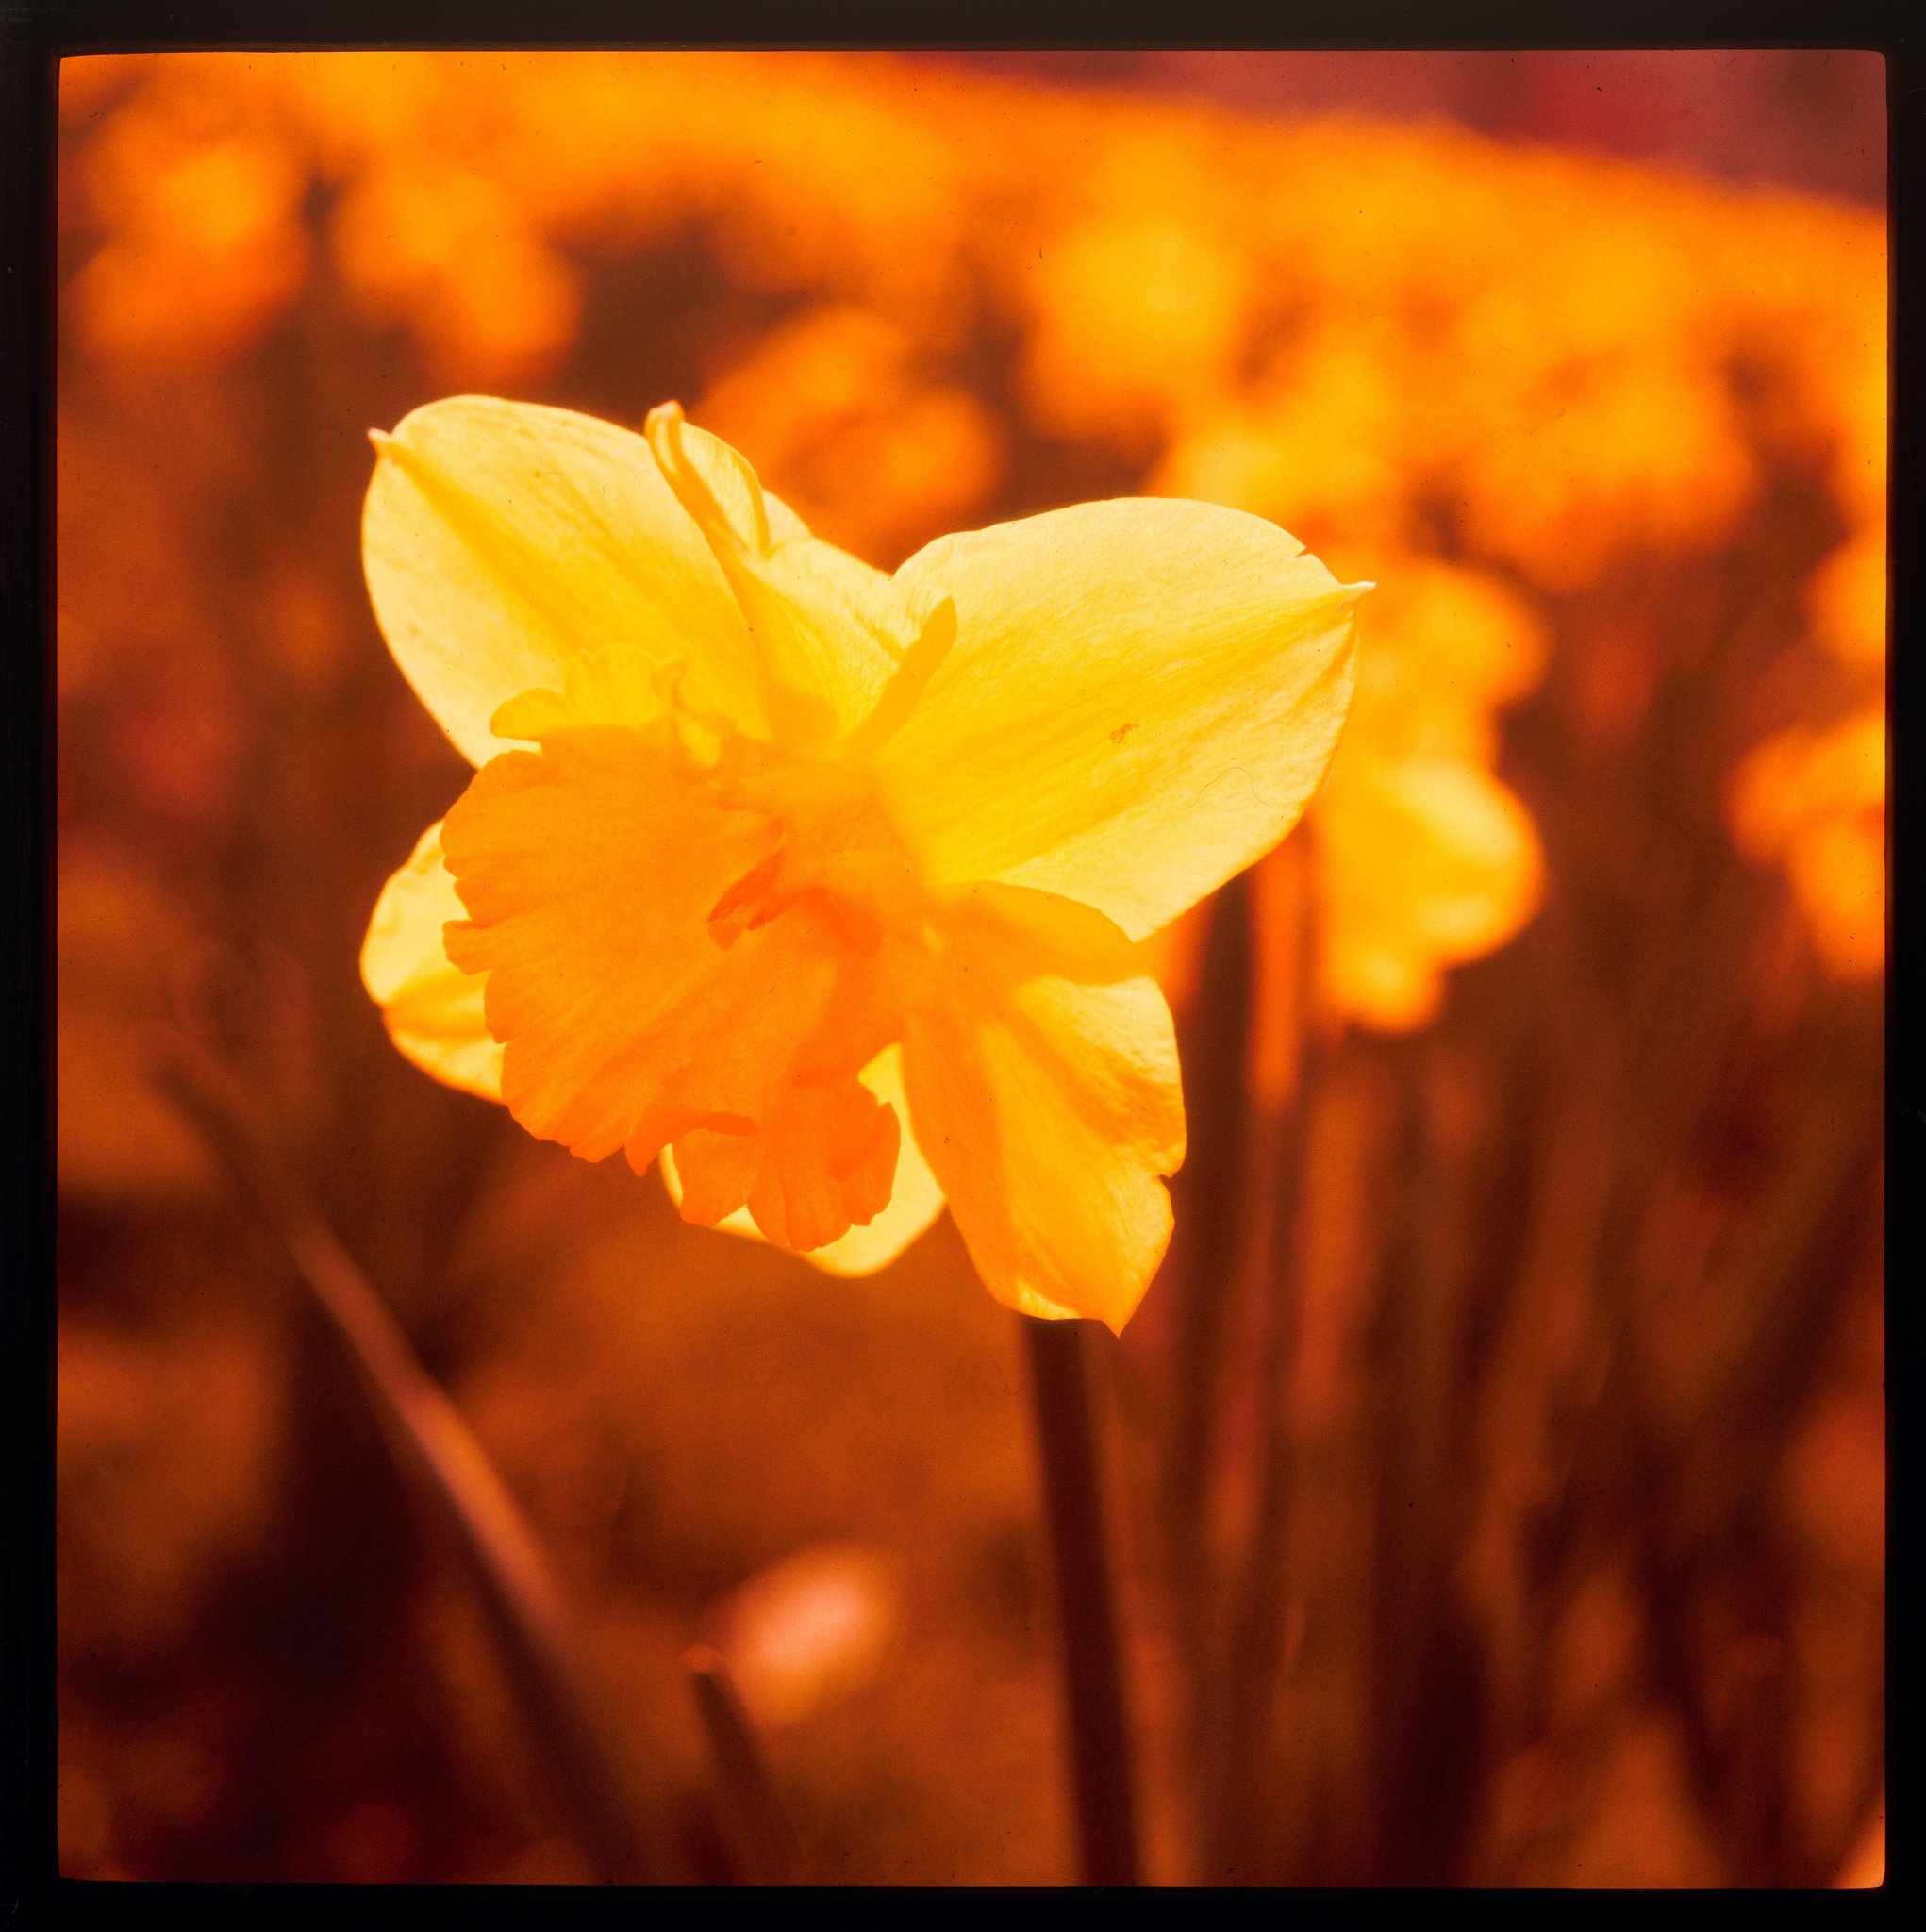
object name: photograph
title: Narcis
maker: Anonymous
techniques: slide